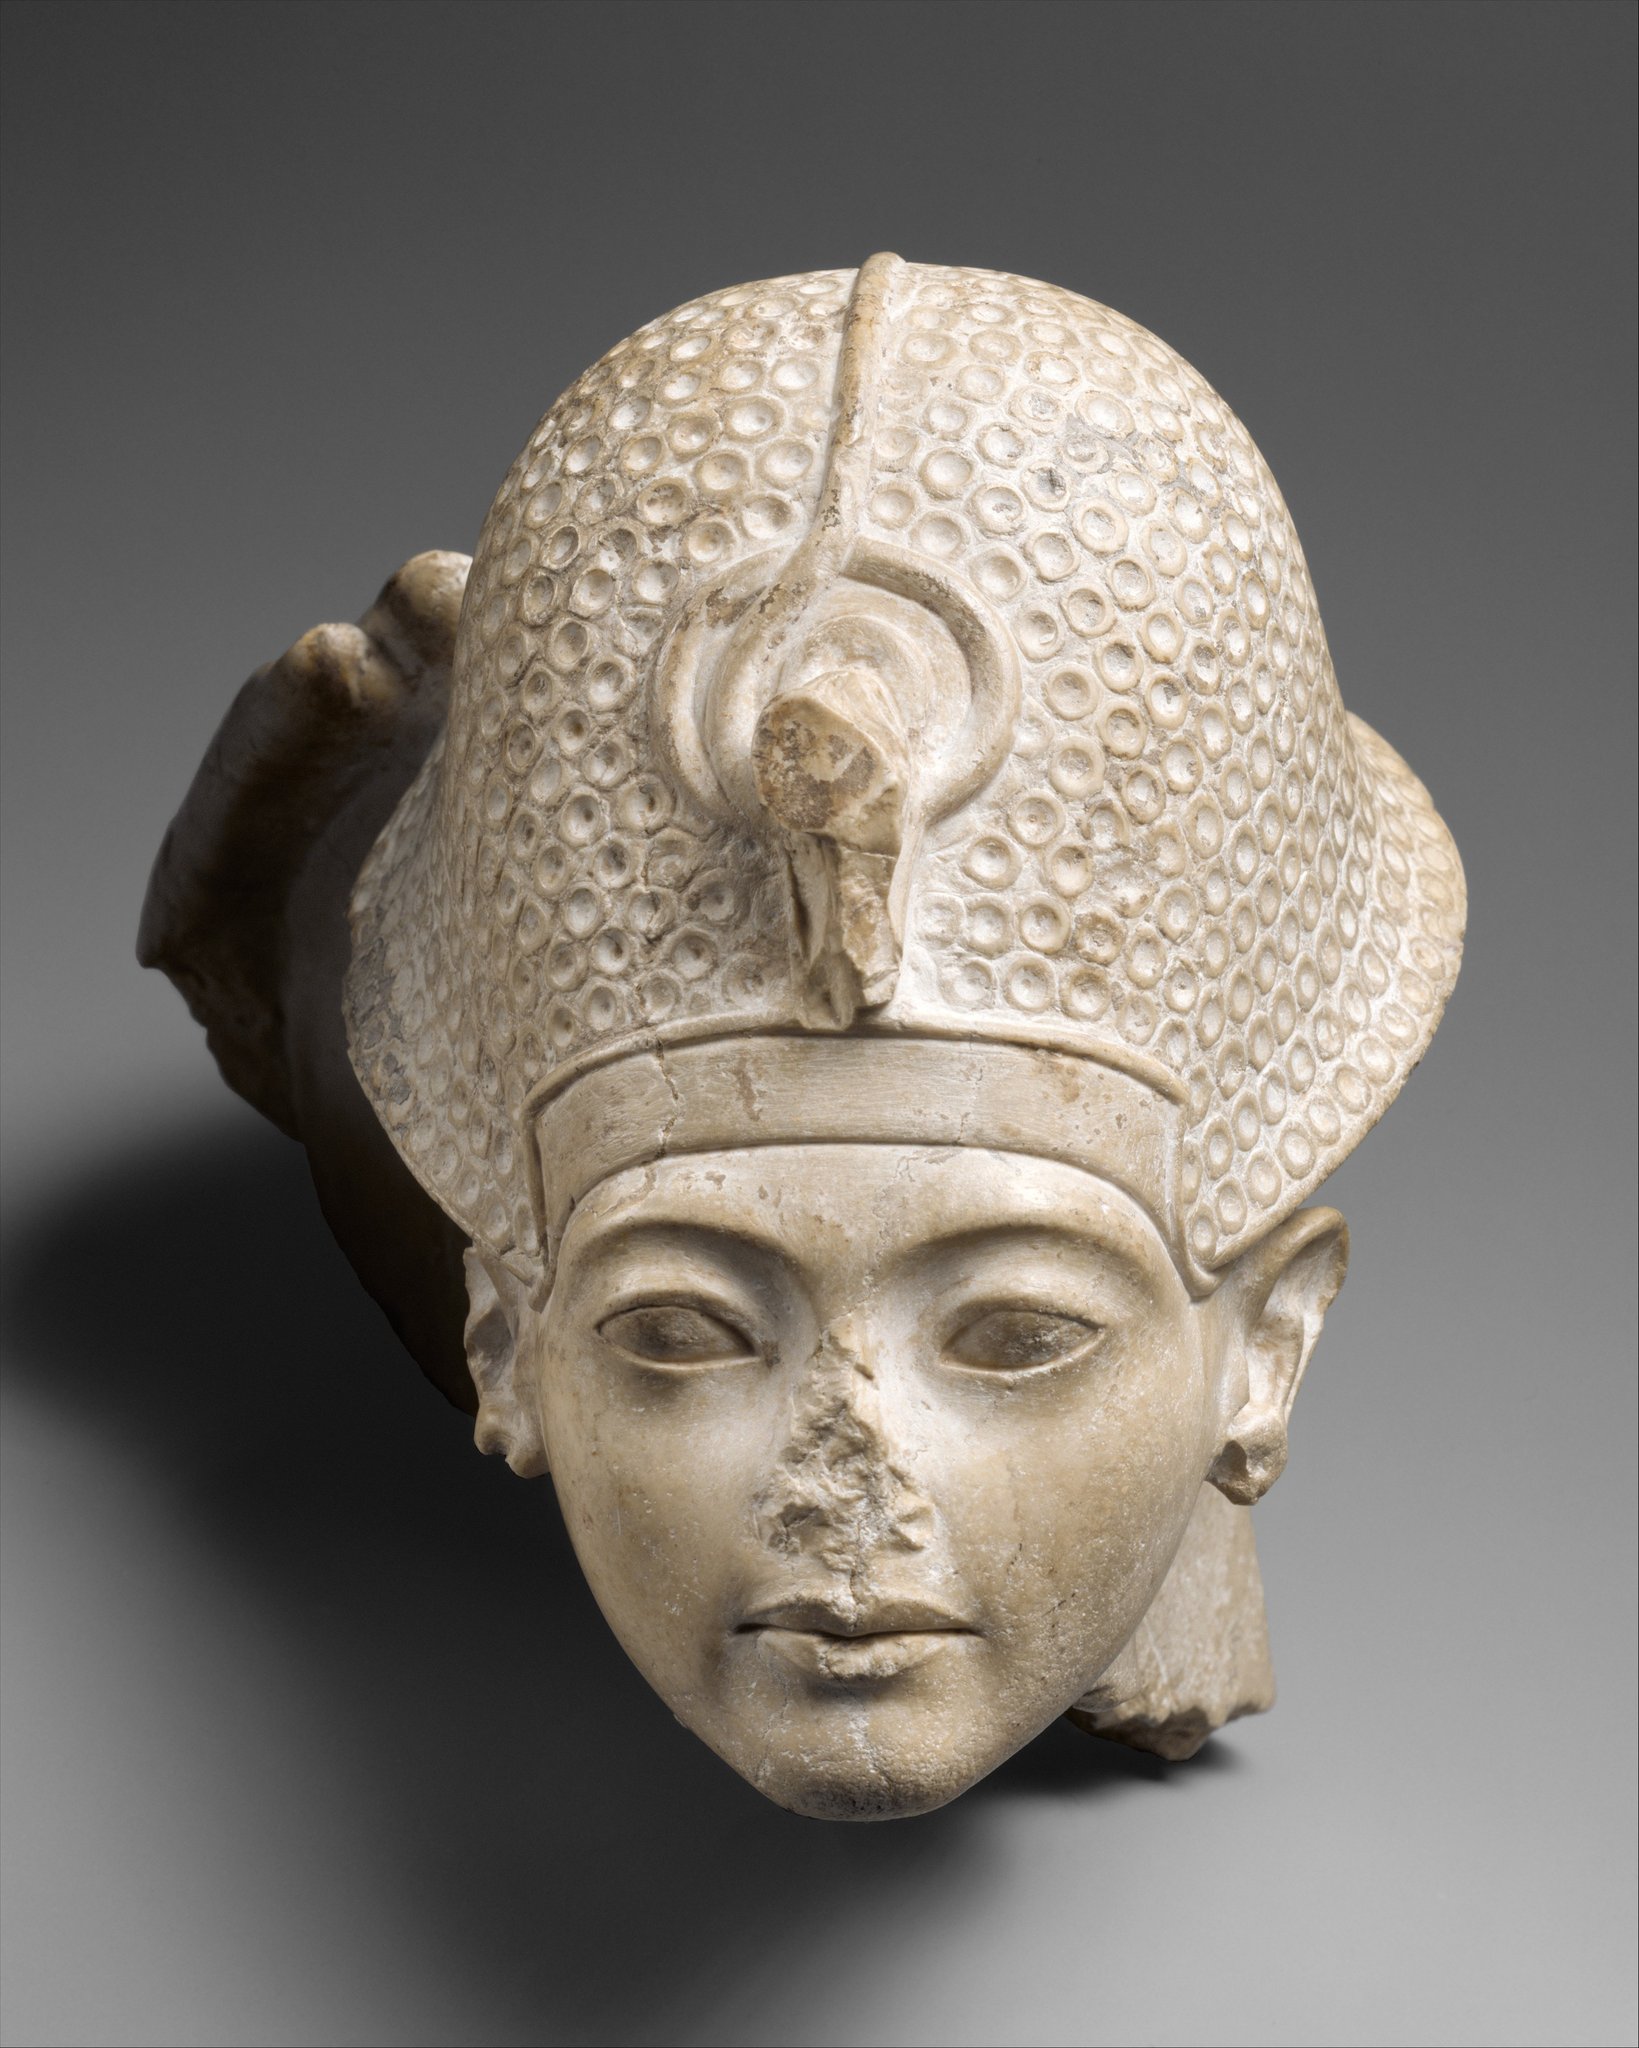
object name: head, tutankhamun, god's hand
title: Head of Tutankhamun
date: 1336-1327 BCE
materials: limestone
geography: egypt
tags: tutankhamun,heads